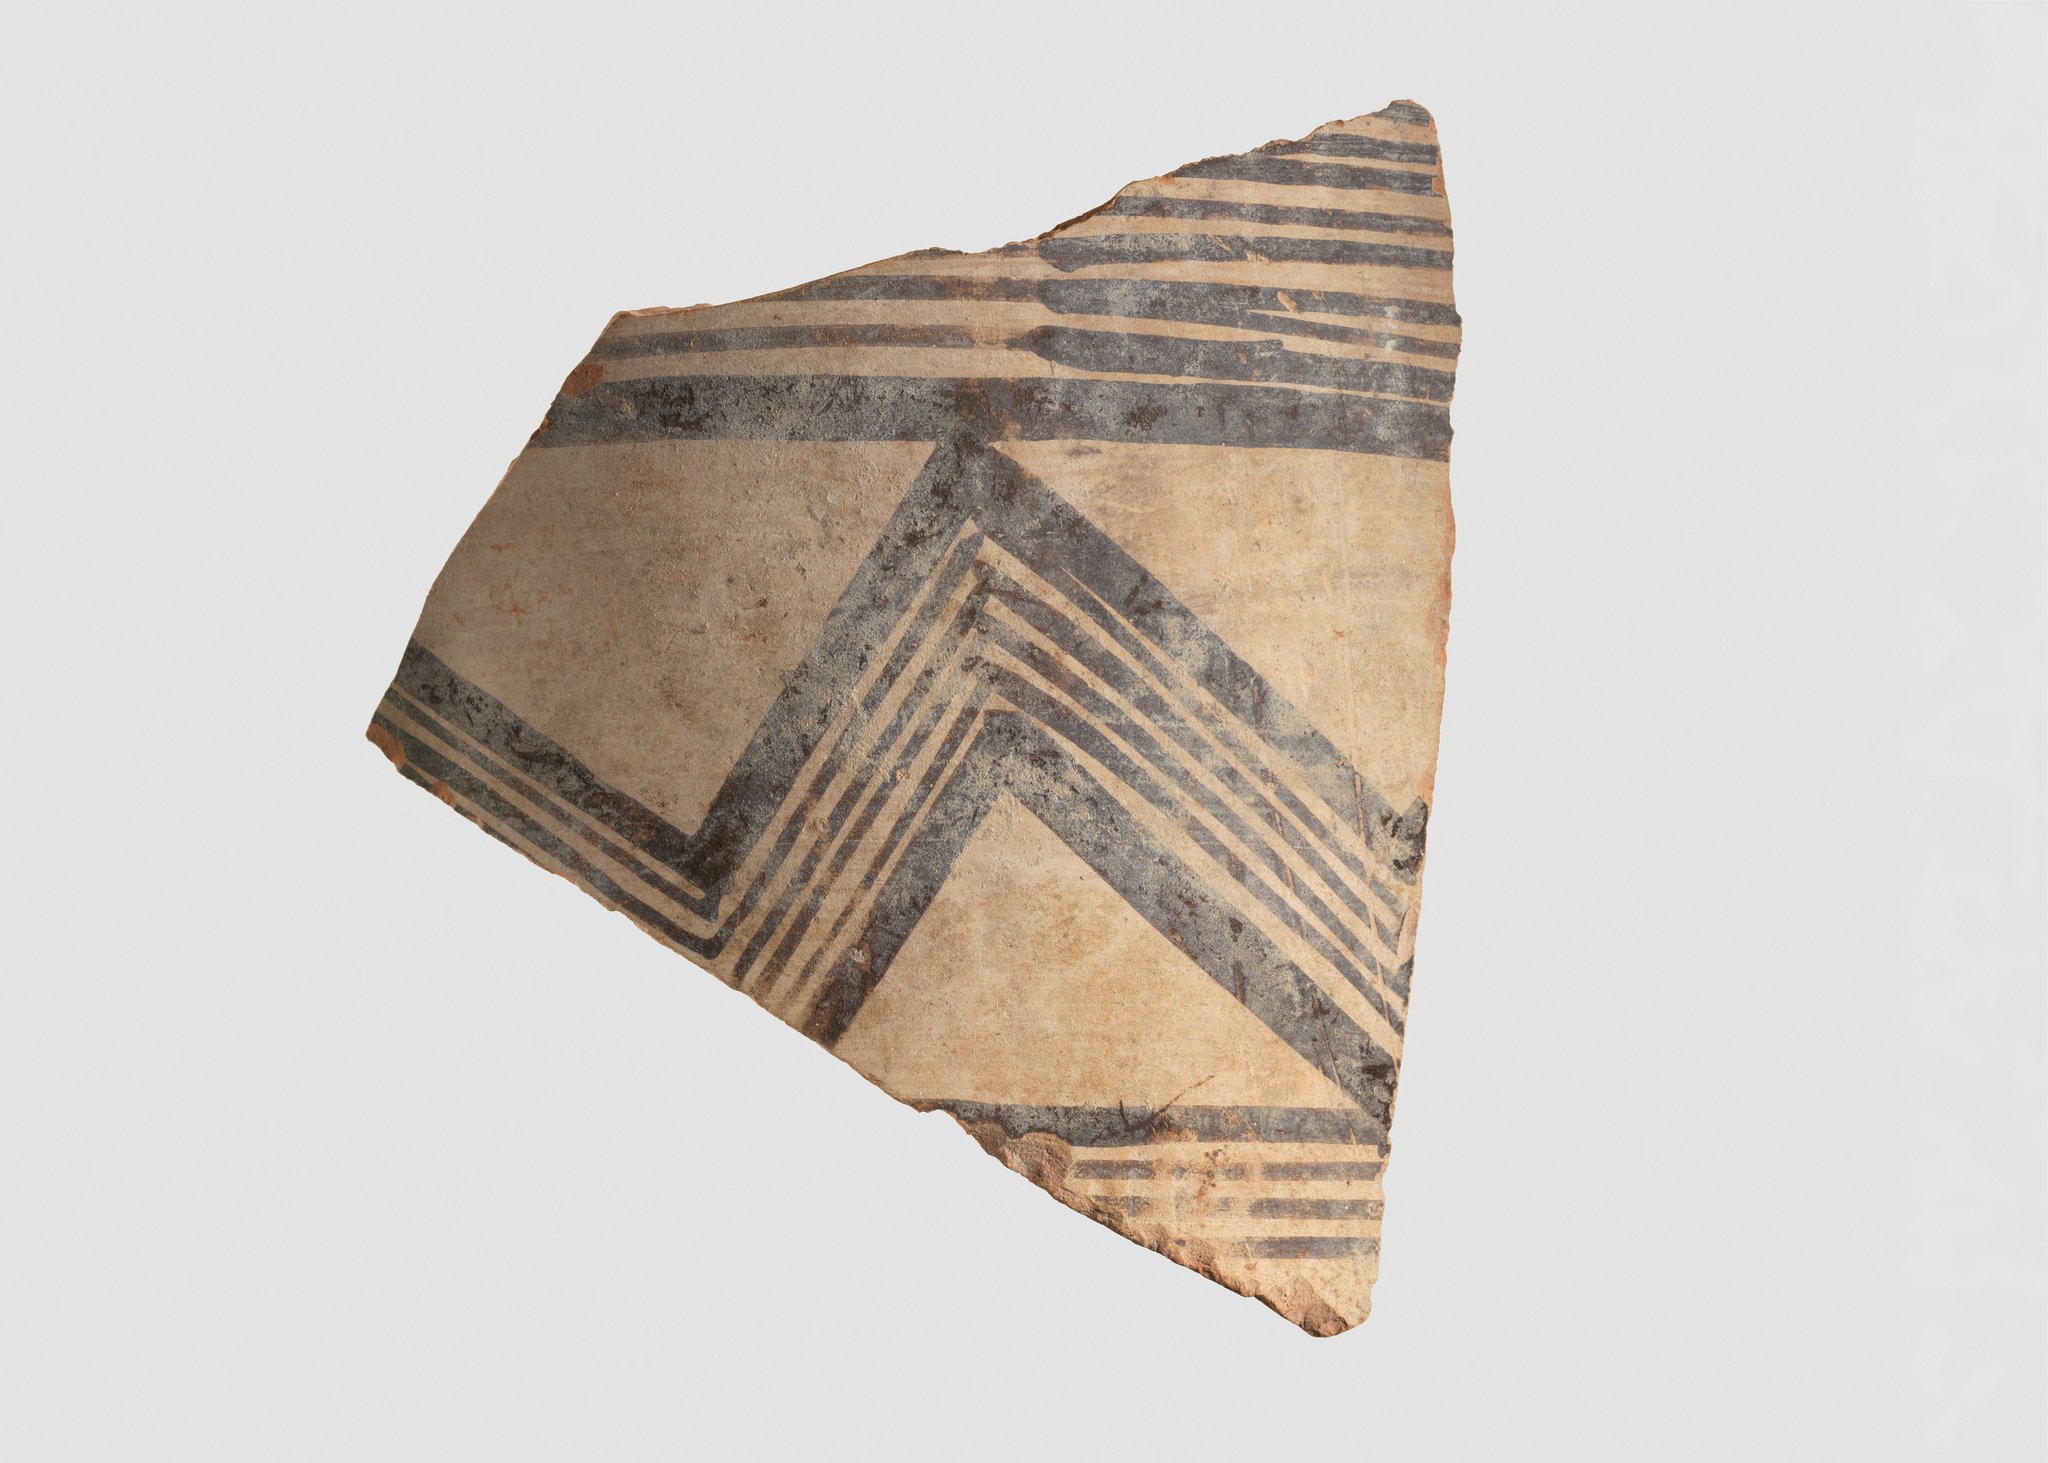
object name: sherd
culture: indus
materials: ceramic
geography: indus region